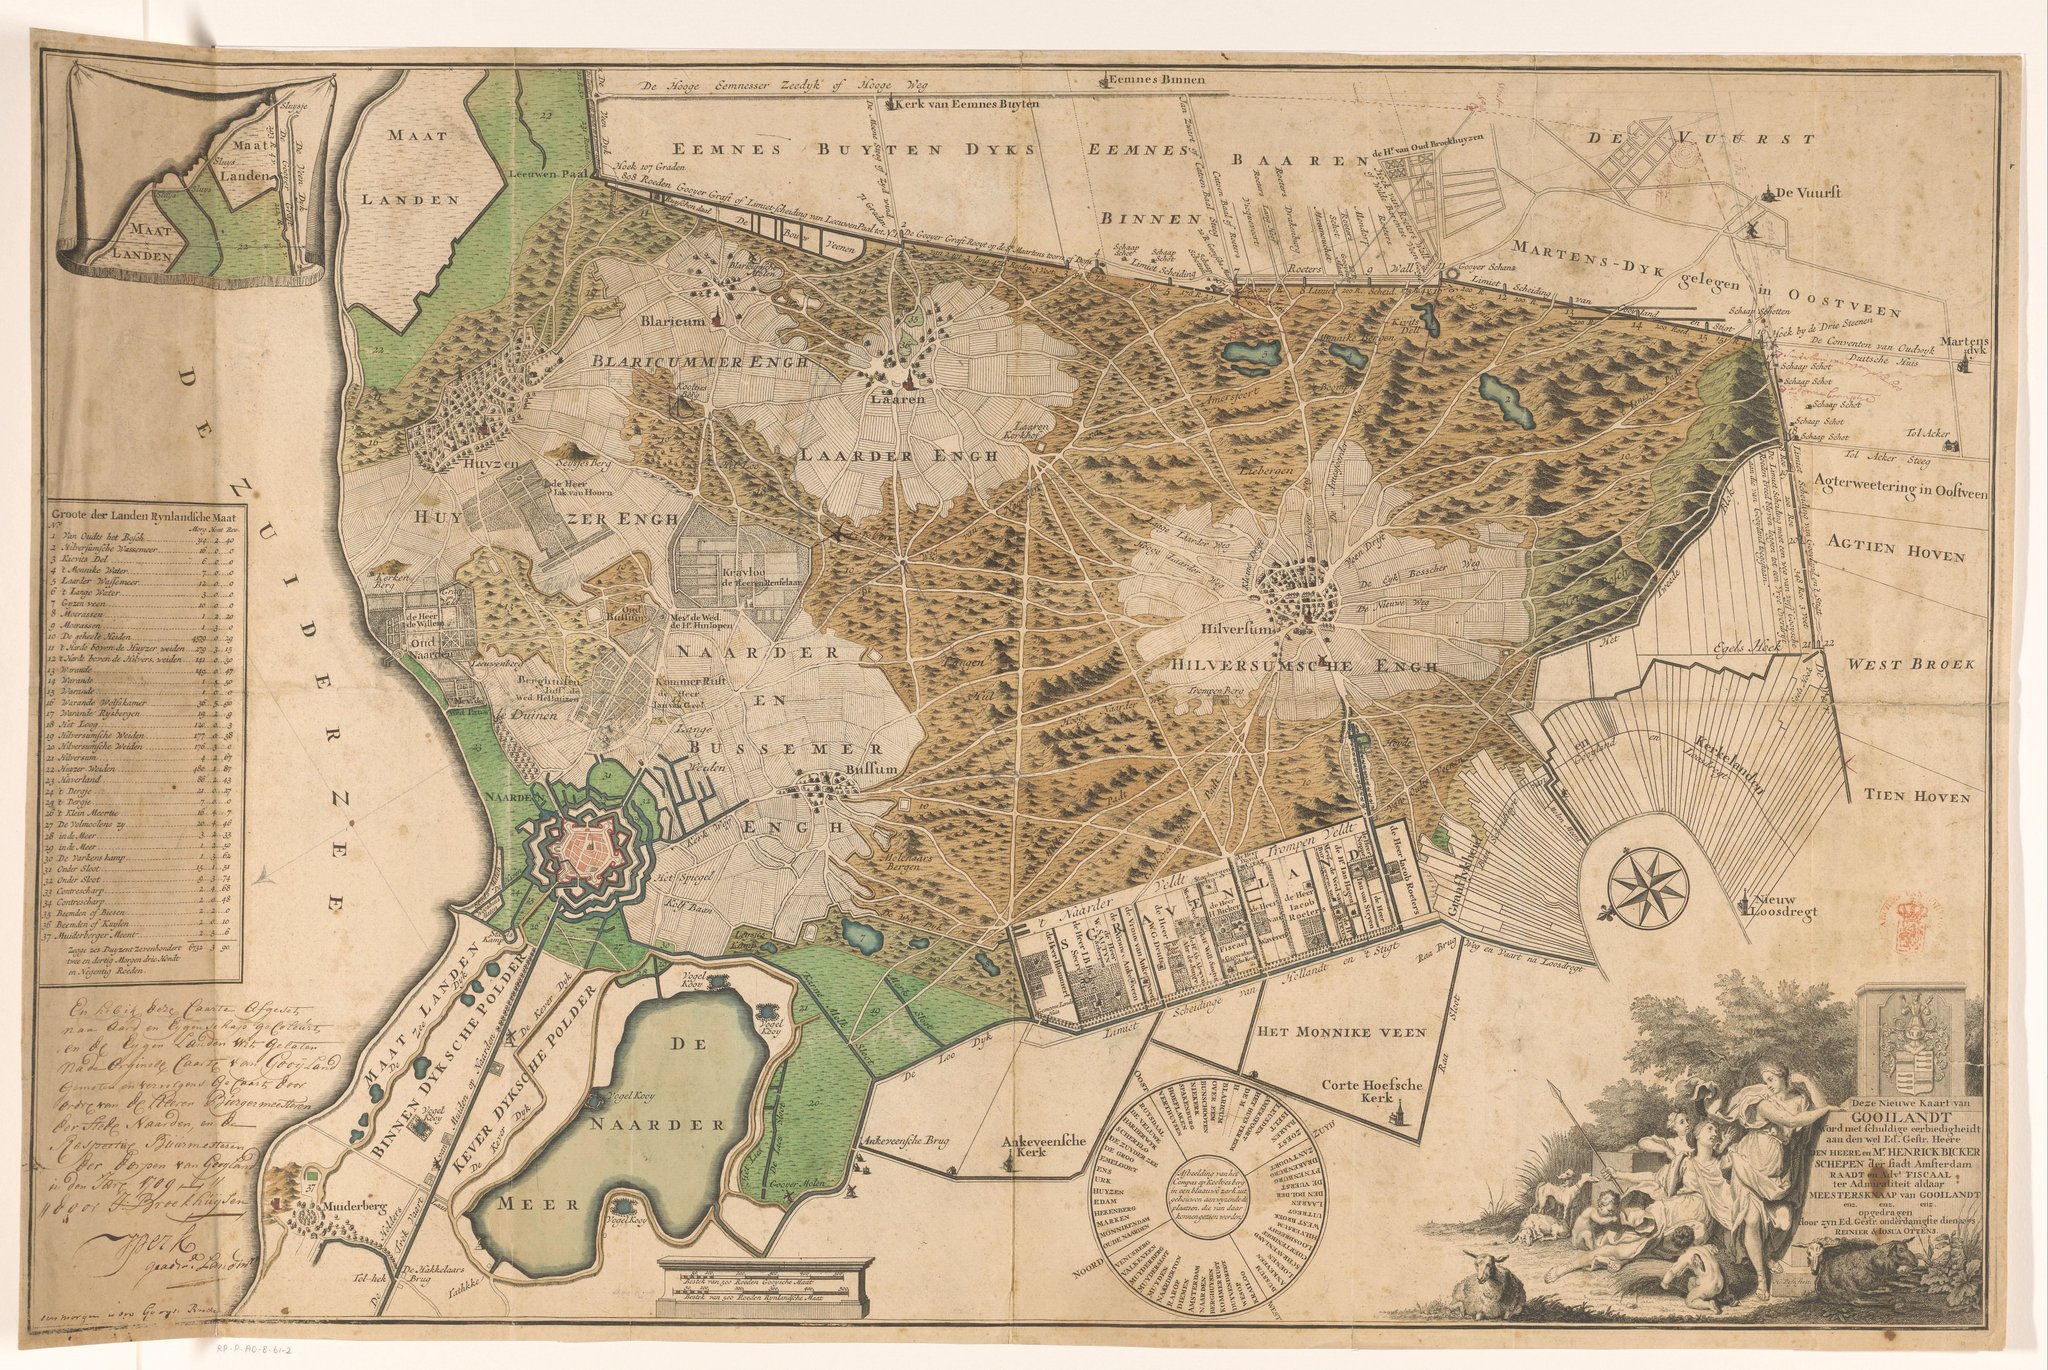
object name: print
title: Nieuwe kaart van Gooilandt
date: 1726-1738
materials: ink, paper, pencil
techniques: engraving, etching, hand coloring, pen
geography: amsterdam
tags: mayor, hendrick hendricksz. bicker (ii), (story of) diana (artemis), maps of separate countries or regions, hunting dogs, sheep, armorial bearing, heraldry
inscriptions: inscription: ‘En heb ik deze caarte afgeset naa aard en eygense hap gecoleurt en de eygen landen wit gelaten na de orginele caarte van Gooijland gemeten en vervolgens gecaart door ordre van de Heeren Burgermeesteren der stede Naarden, en de respective Buurmesteren der dorpen van Gooyland in den jare 1709 door J: Broekhuijsen J. Perk geadm.[iteerd] landm[eter] een morgen is 800 Gooyse roede’, collector's mark: Lugt 19, inscription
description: Linksboven een inzetkaart van de Maatlanden, daaronder de legenda. Onderaan links van het midden twee schaalstokken: Bestek van 500 roeden Gooysche maat; Bestek van 500 roeden Rynlandsche maat. Onderaan rechts van het midden een kompas met plaatsnamen uit het gebied. Rechtsonder een cartouche met de opdracht en daarboven het wapen van Hendrick Hendricksz. Bicker (II). Daaromheen jachthonden, schapen, putti en drie vrouwfiguren waaronder Diana.